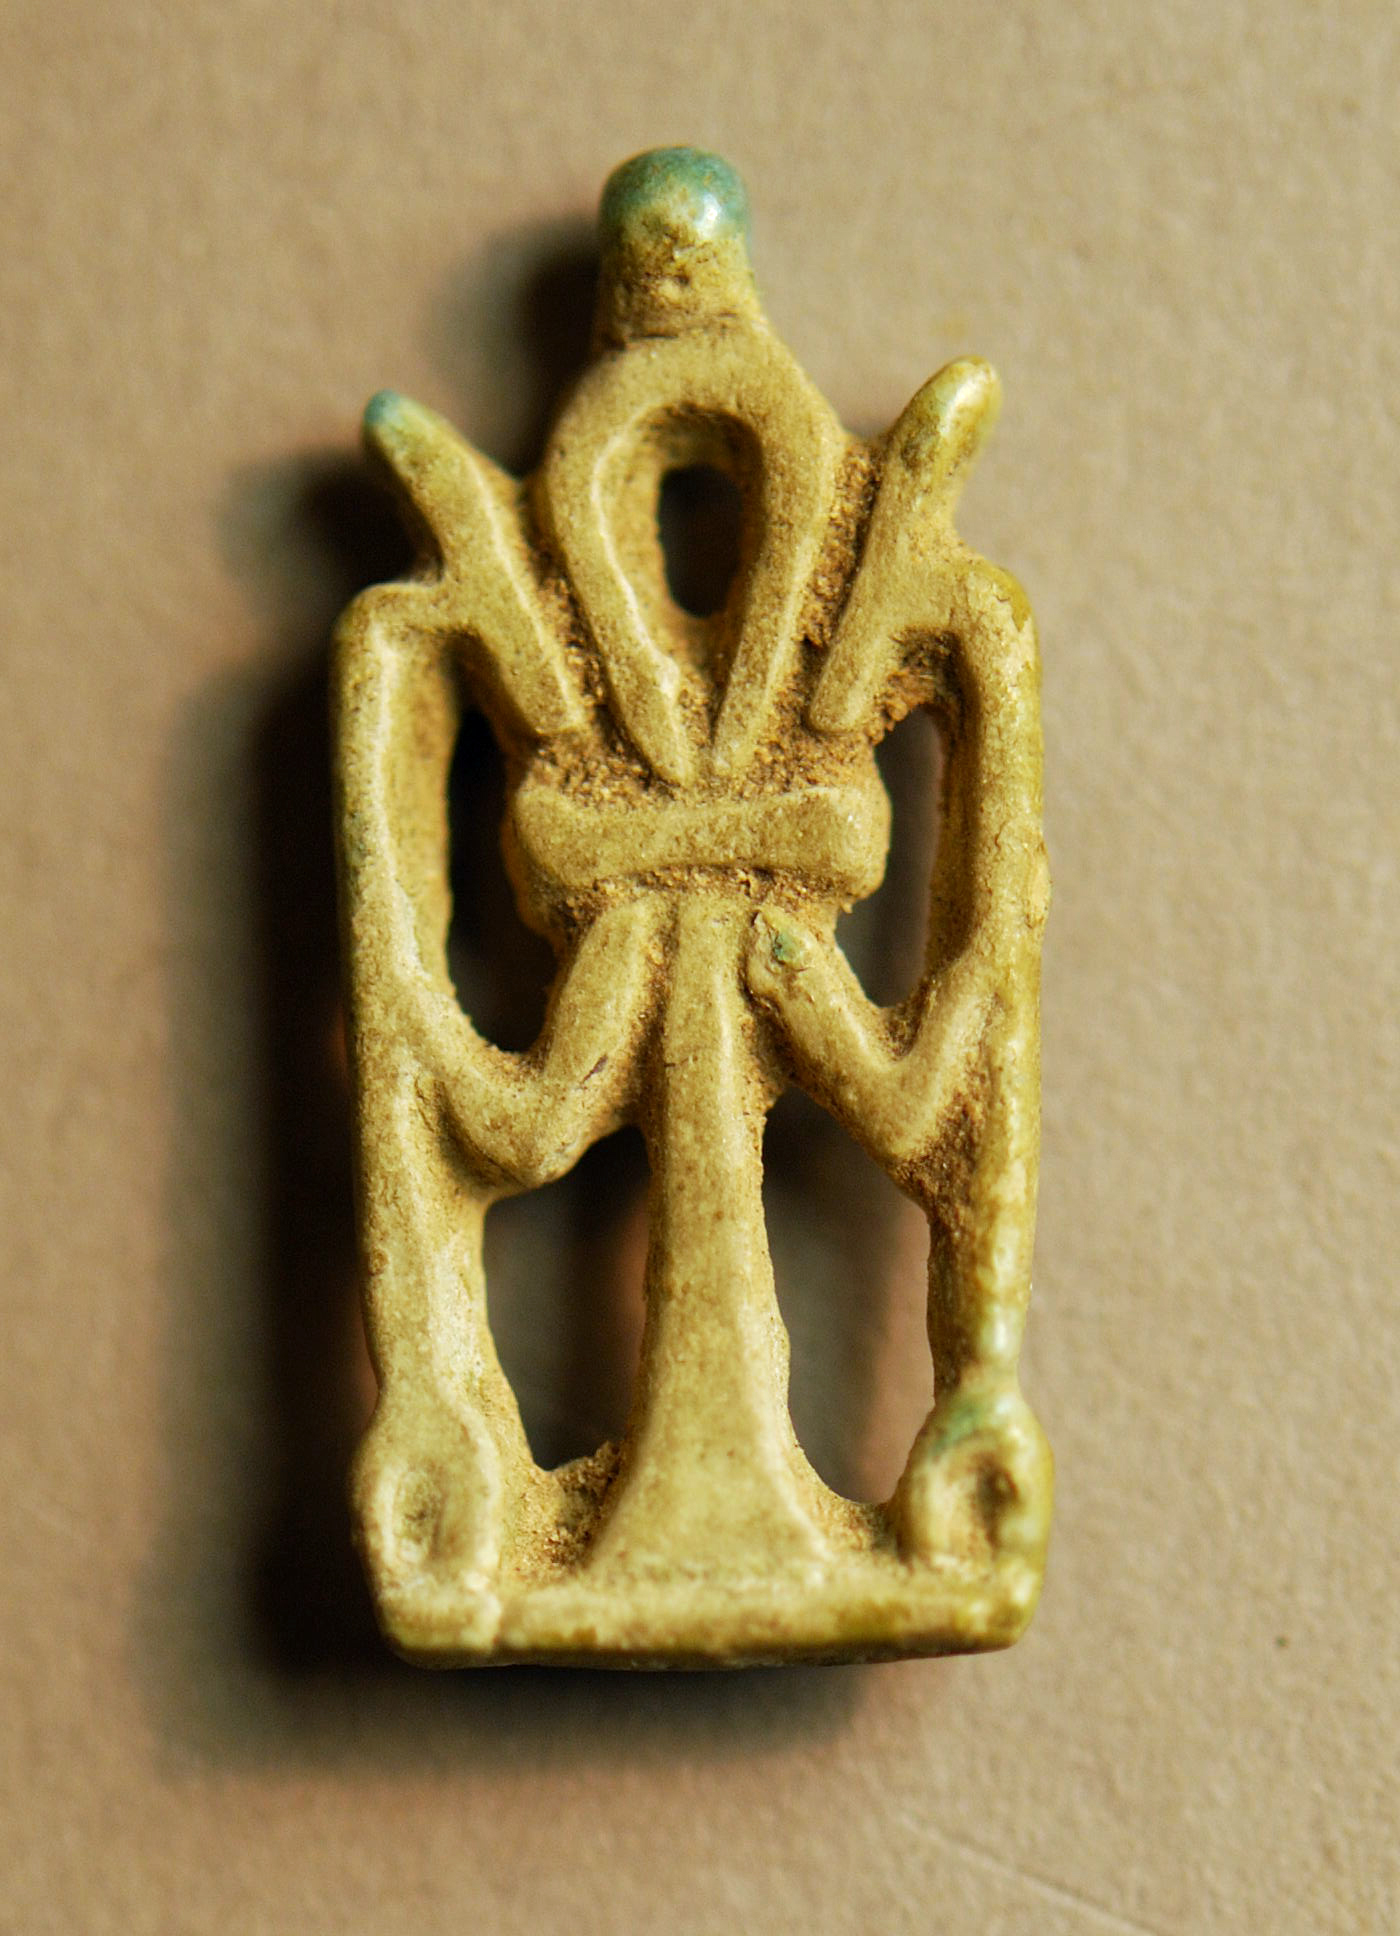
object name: amulet, ankh, wa scepter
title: Amulet with an Ankh and Two Was Scepters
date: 1390-1352 BCE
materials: faience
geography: egypt